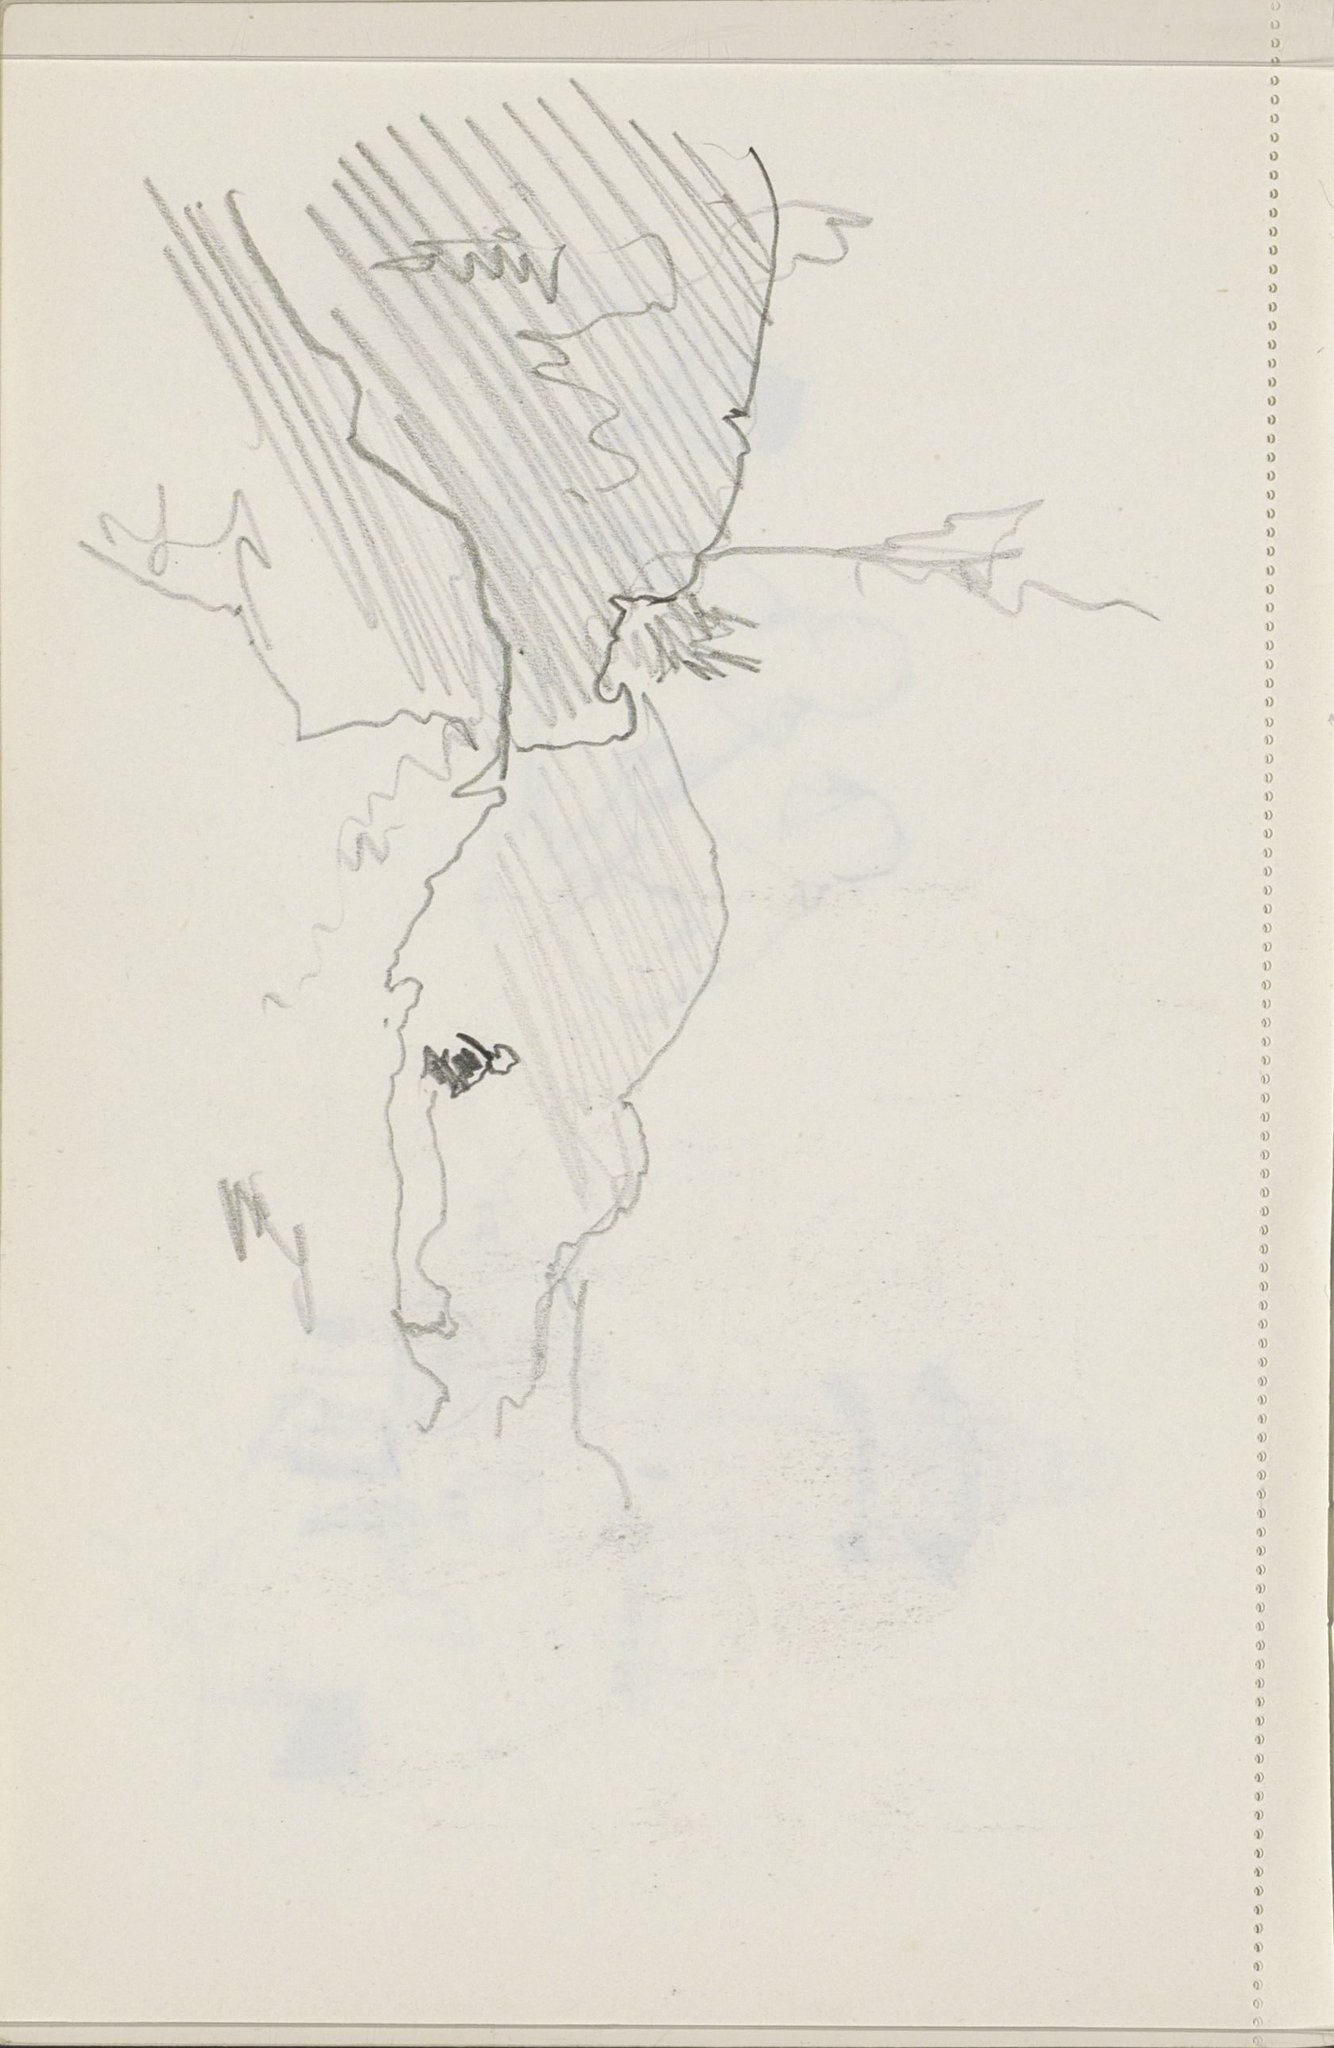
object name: sketchbook leaf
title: Figuur in een heuvellandschap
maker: cornelis vreedenburgh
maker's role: draughtsman, print maker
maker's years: 1880-1946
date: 1936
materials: paper, pencil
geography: maghreb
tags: landscapes (+ landscape with figures, staffage)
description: Blad 49 verso uit een schetsboek met 73 bladen.